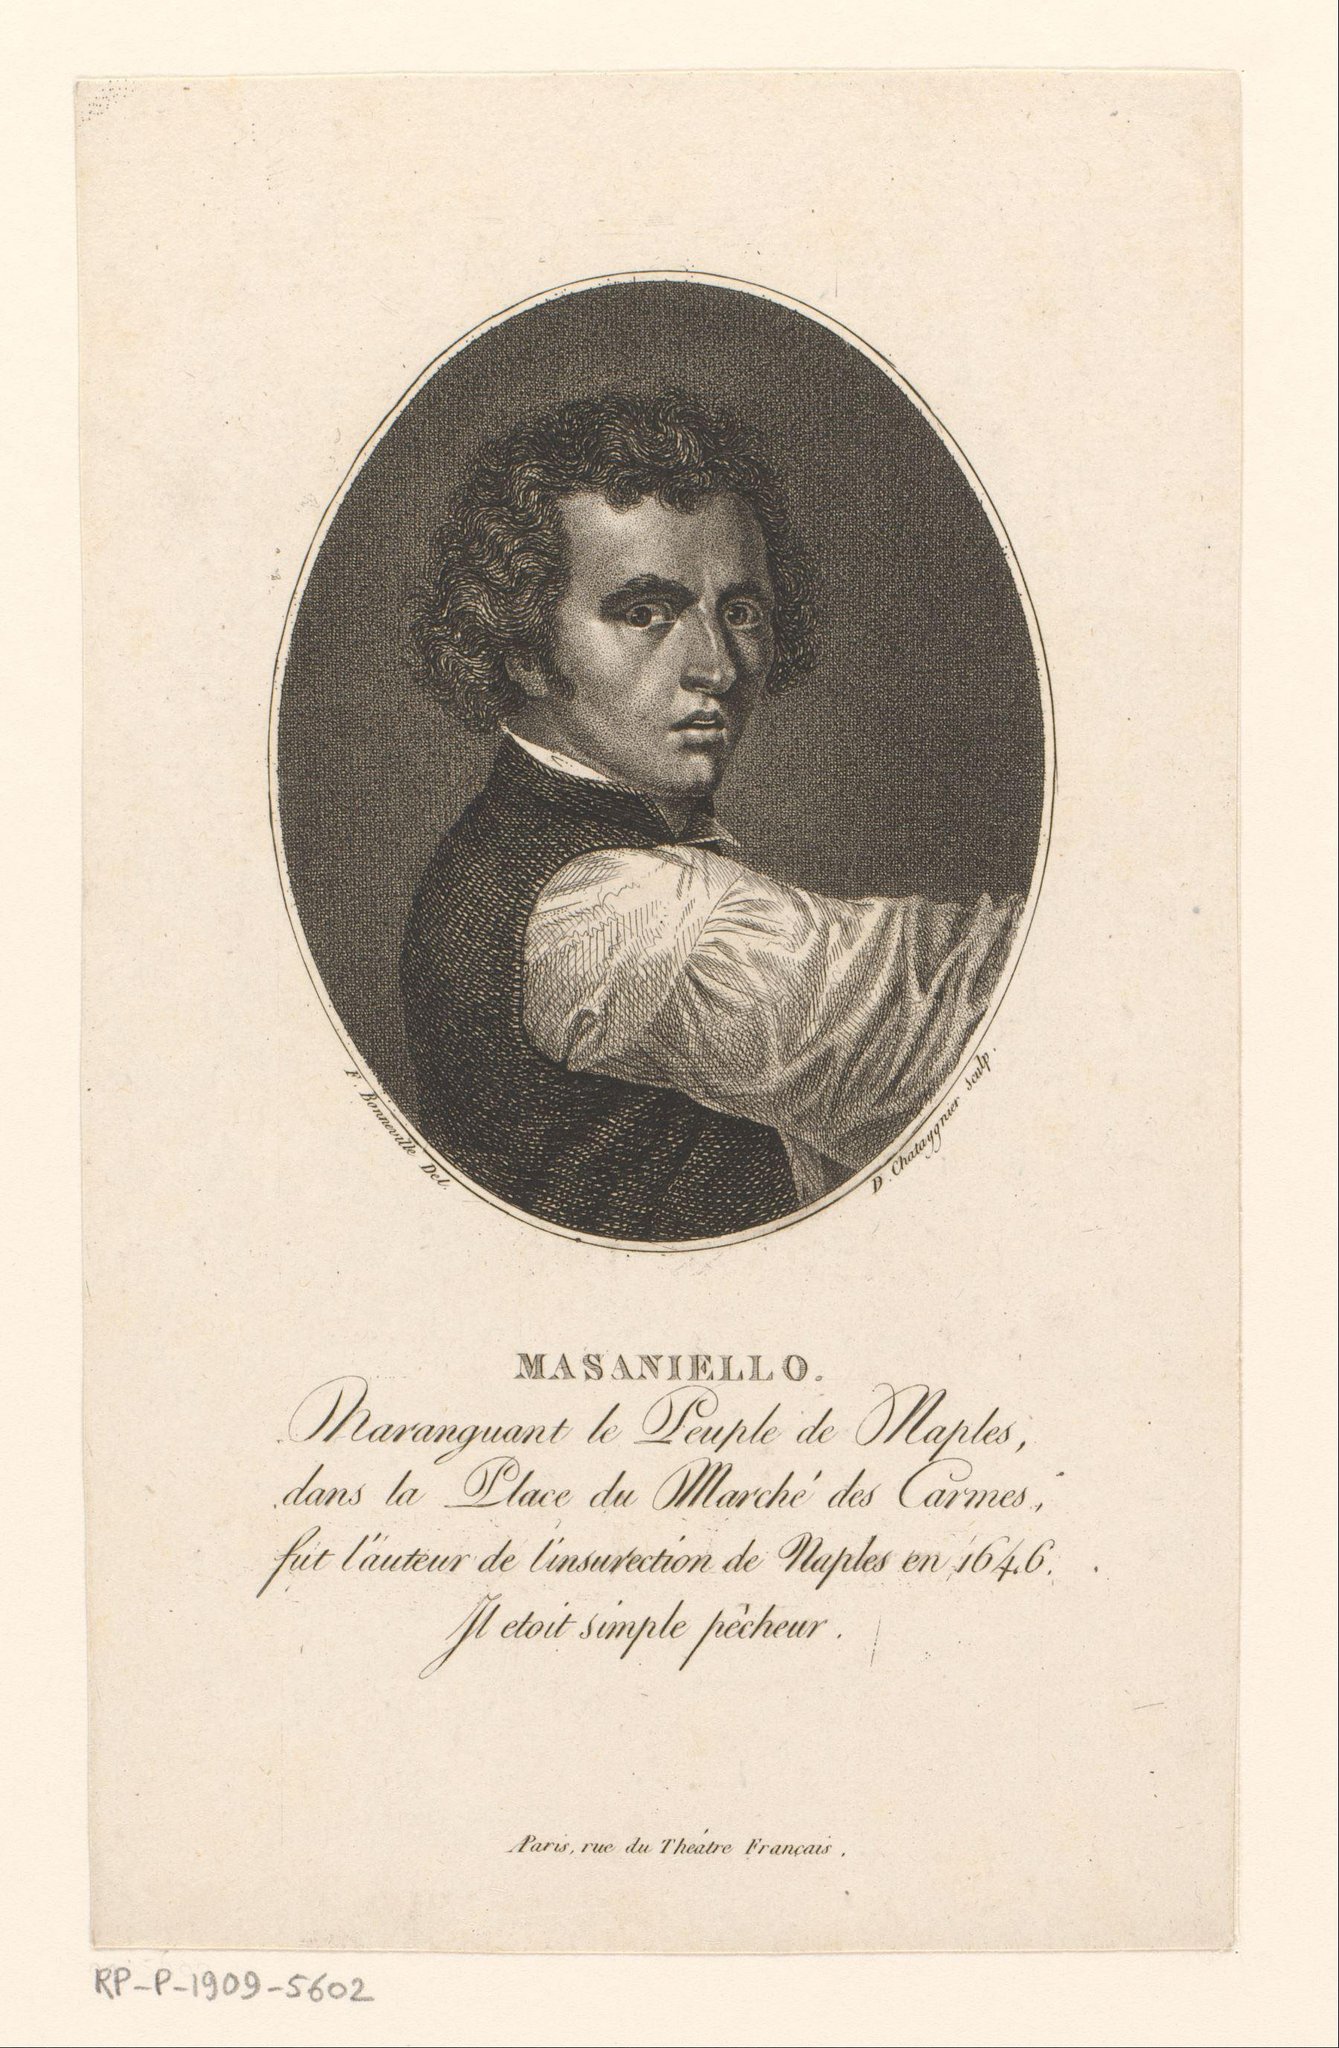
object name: print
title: Portret van Masaniello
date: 1700-1799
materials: paper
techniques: etching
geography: france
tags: amalfi, naples, historical persons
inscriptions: collector's mark: Lugt 2228